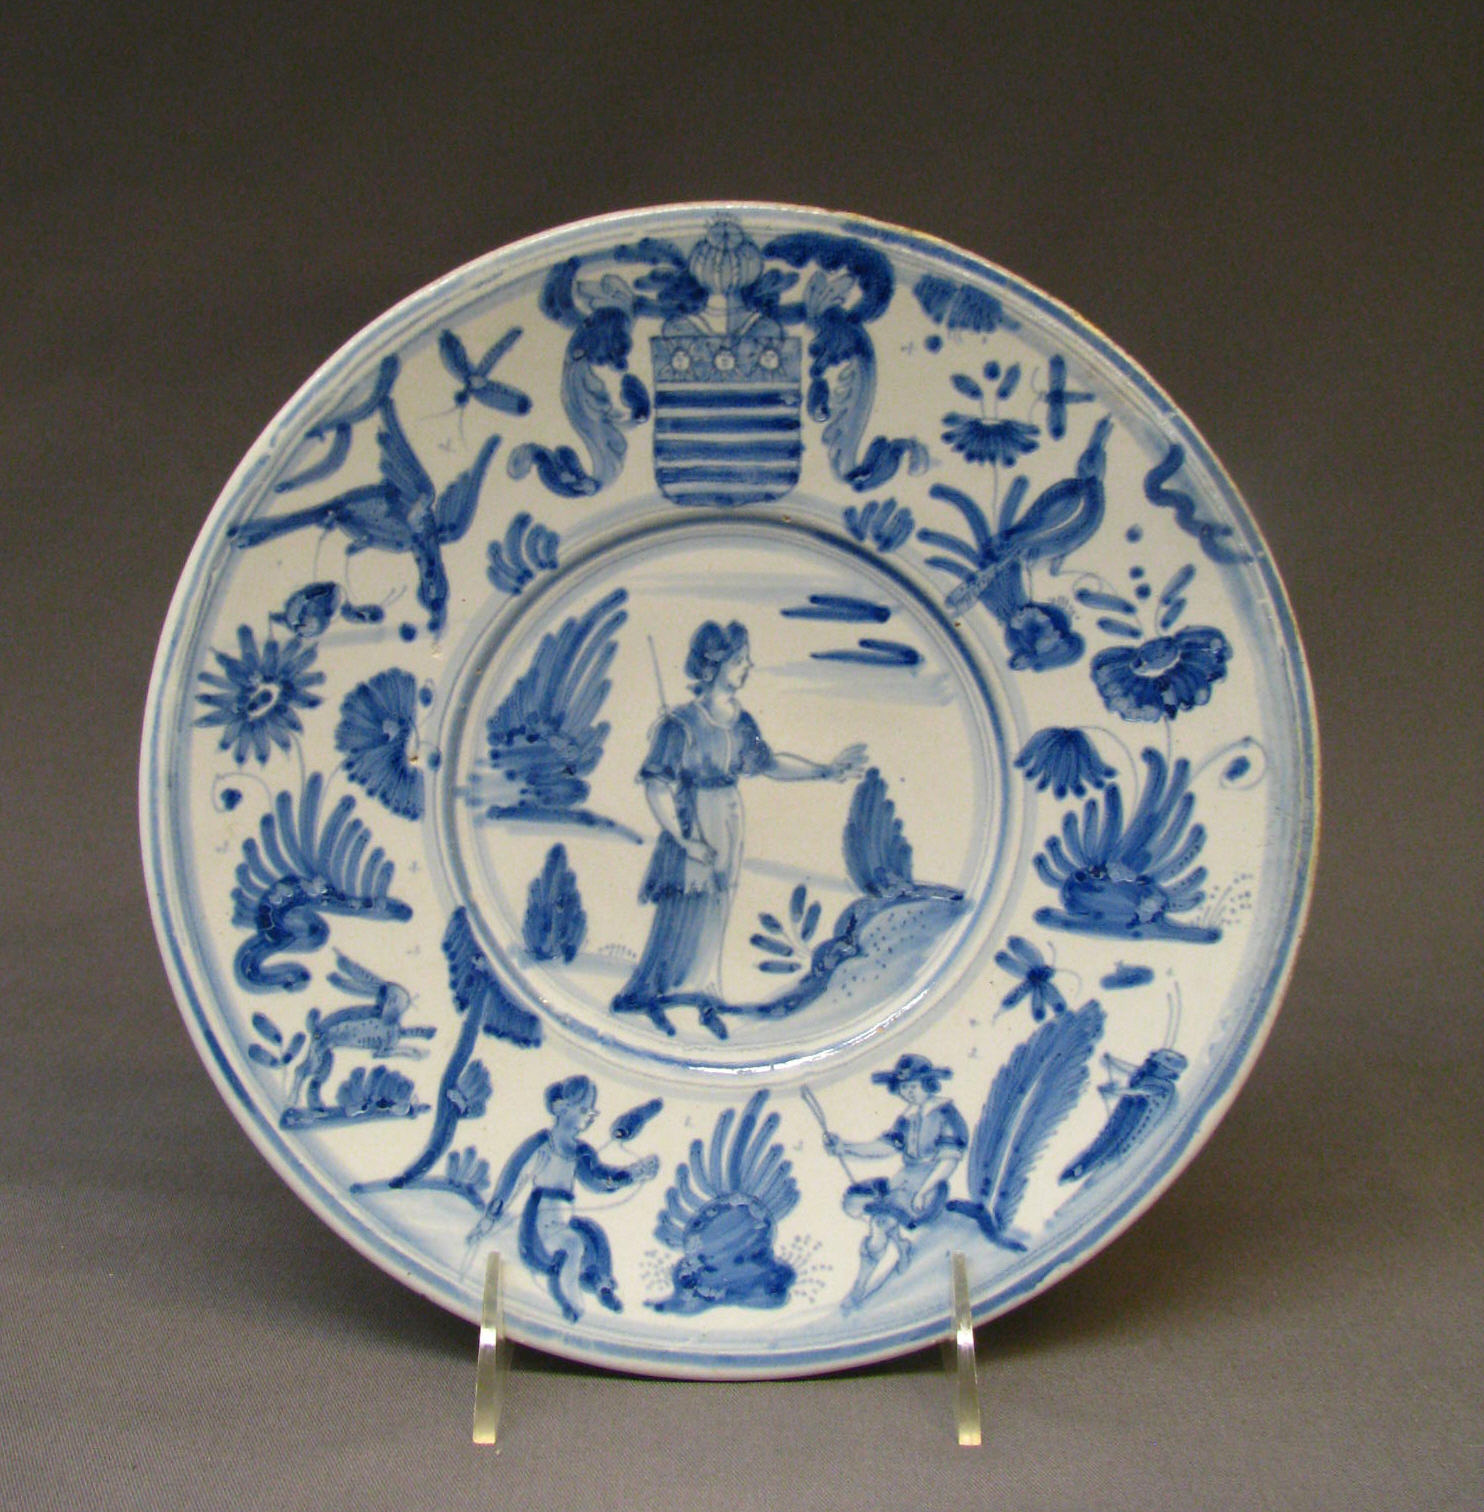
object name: plate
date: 1634-1666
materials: faience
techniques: glazing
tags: birds,women,flowers,coat of arms